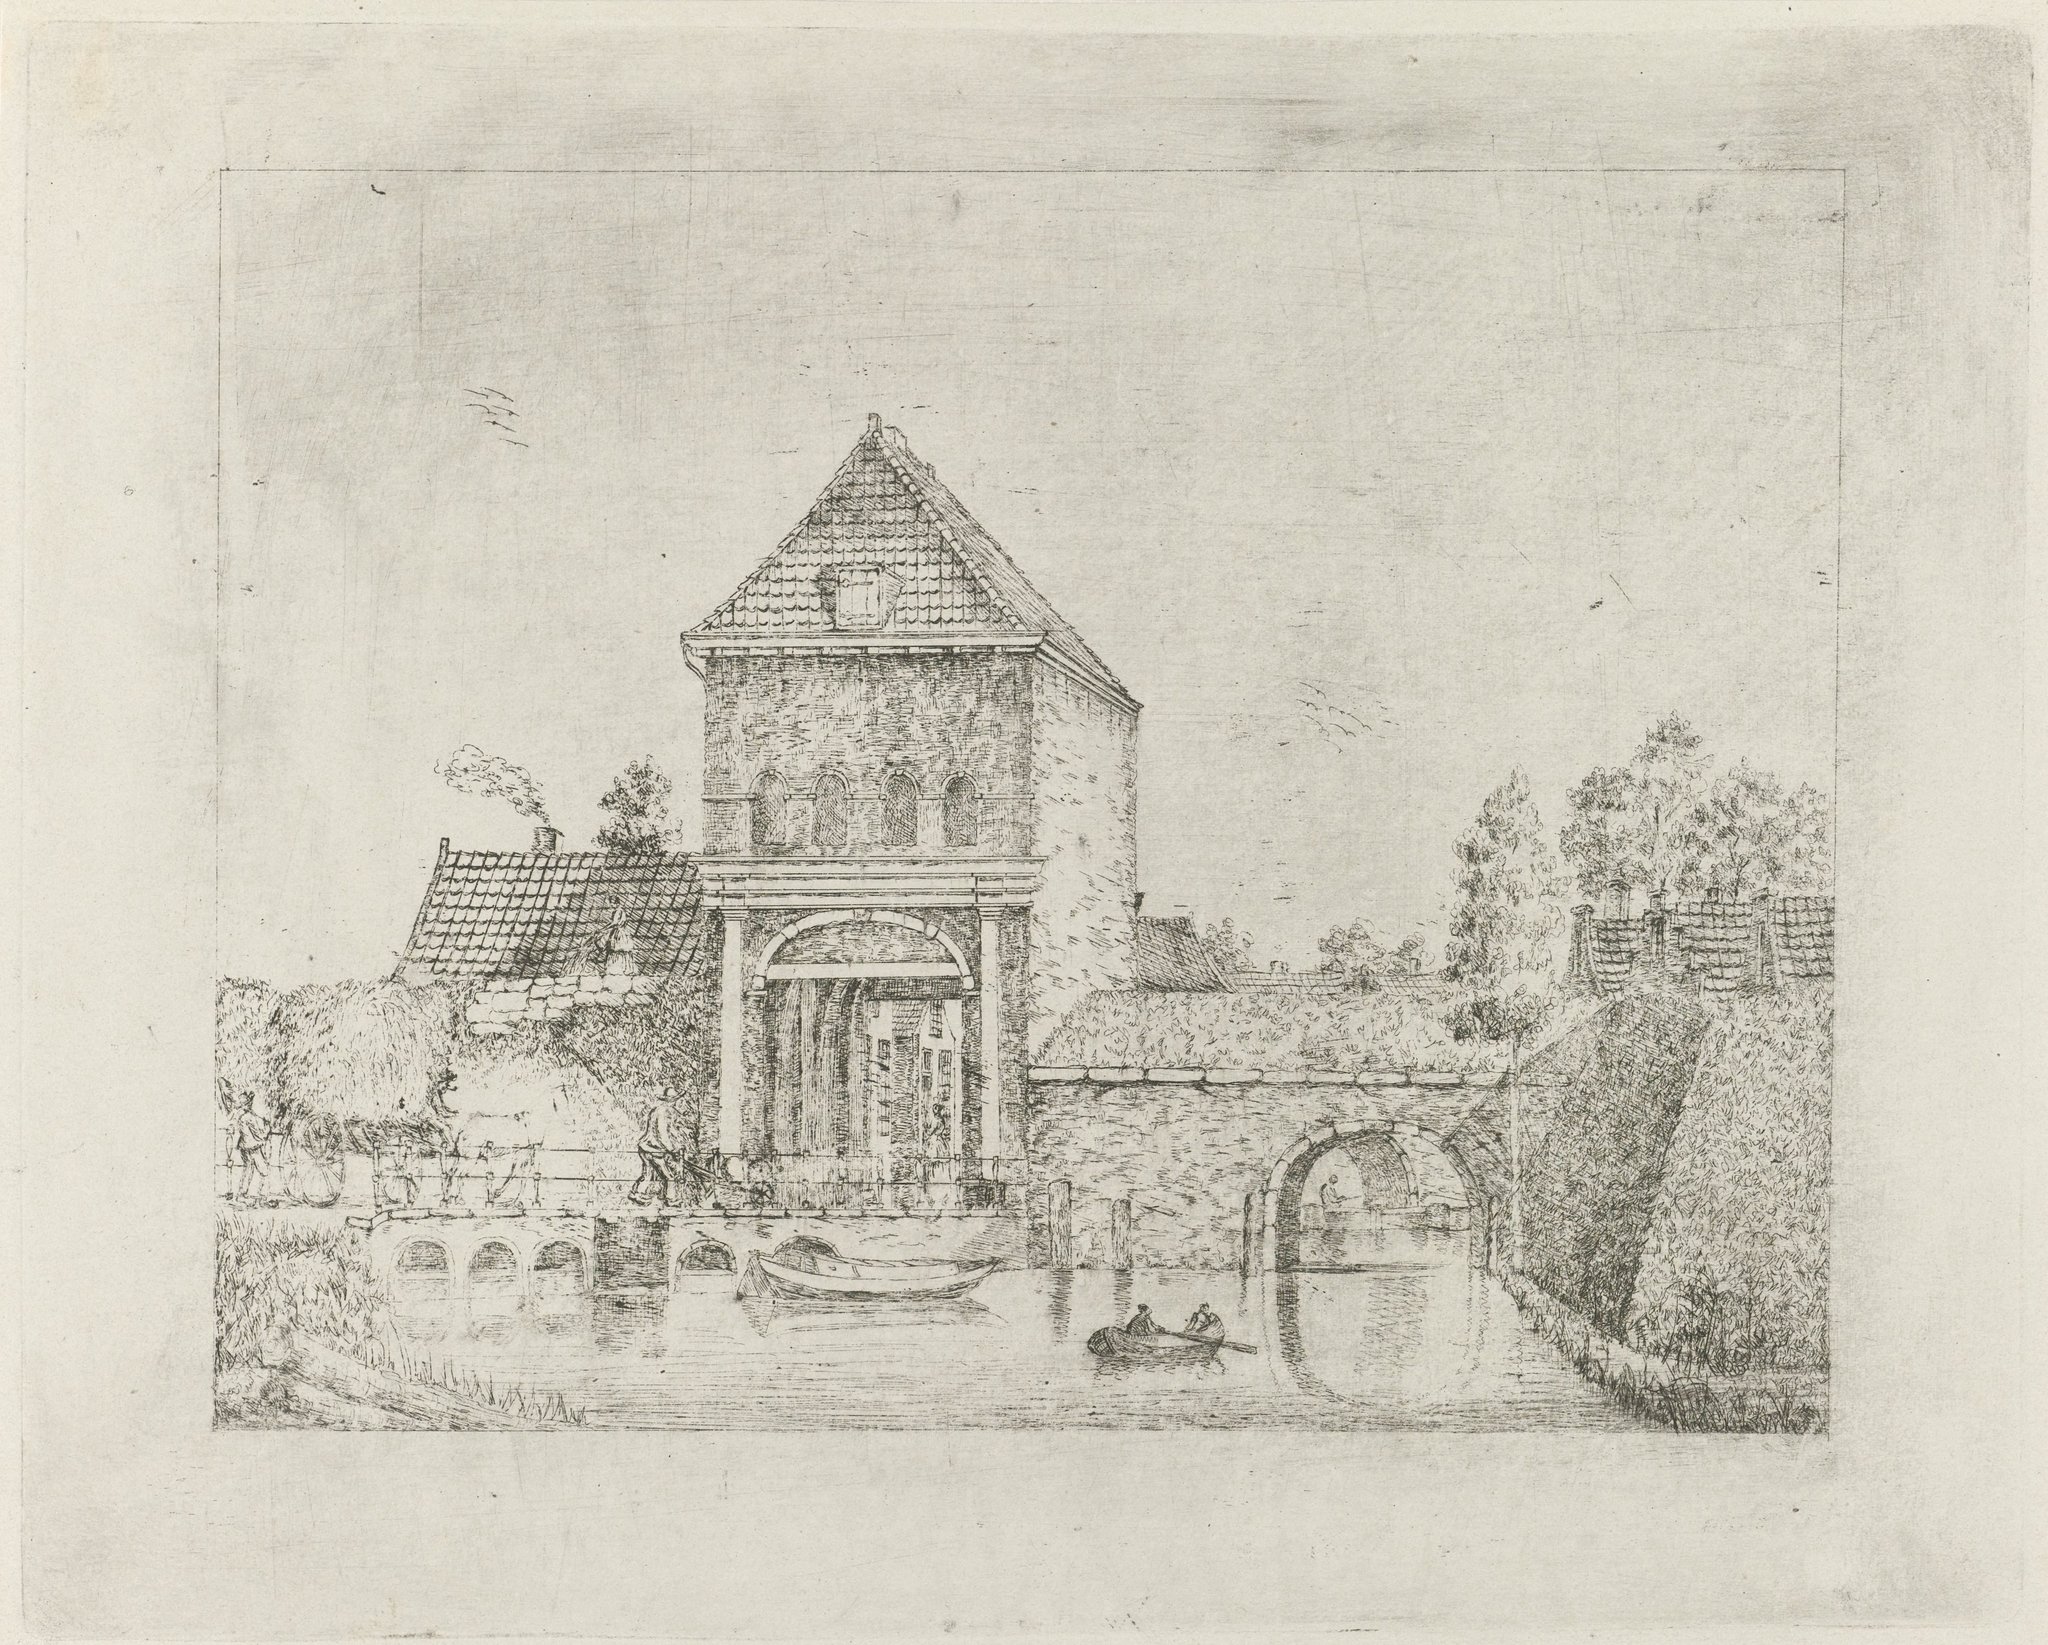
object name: print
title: Linschoterpoort te Oudewater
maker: eberhard cornelis rahms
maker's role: print maker, publisher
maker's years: 1823-1907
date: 1810-1860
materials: paper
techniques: etching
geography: oudewater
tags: rowing-boat, canoe, etc., hay-wagon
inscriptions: collector's mark: Lugt 2228, inscription: ‘[...] N 4 - Geetst October 1860 / De Linschoter Poort / te Oudewater / afgebroken 1857 / na de teekening met eenige [...] figuren / [...] voor het plaatje [...] op Steen / geteekend had voor dezelfde Poort / na de natuur geteekend. ECR f / Gedrukt october 1860’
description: Gezicht op de Linschoterpoort te Oudewater met op de voorgrond water waar enkele boten varen. Links rijdt een hooiwagen over de brug naar de poort.